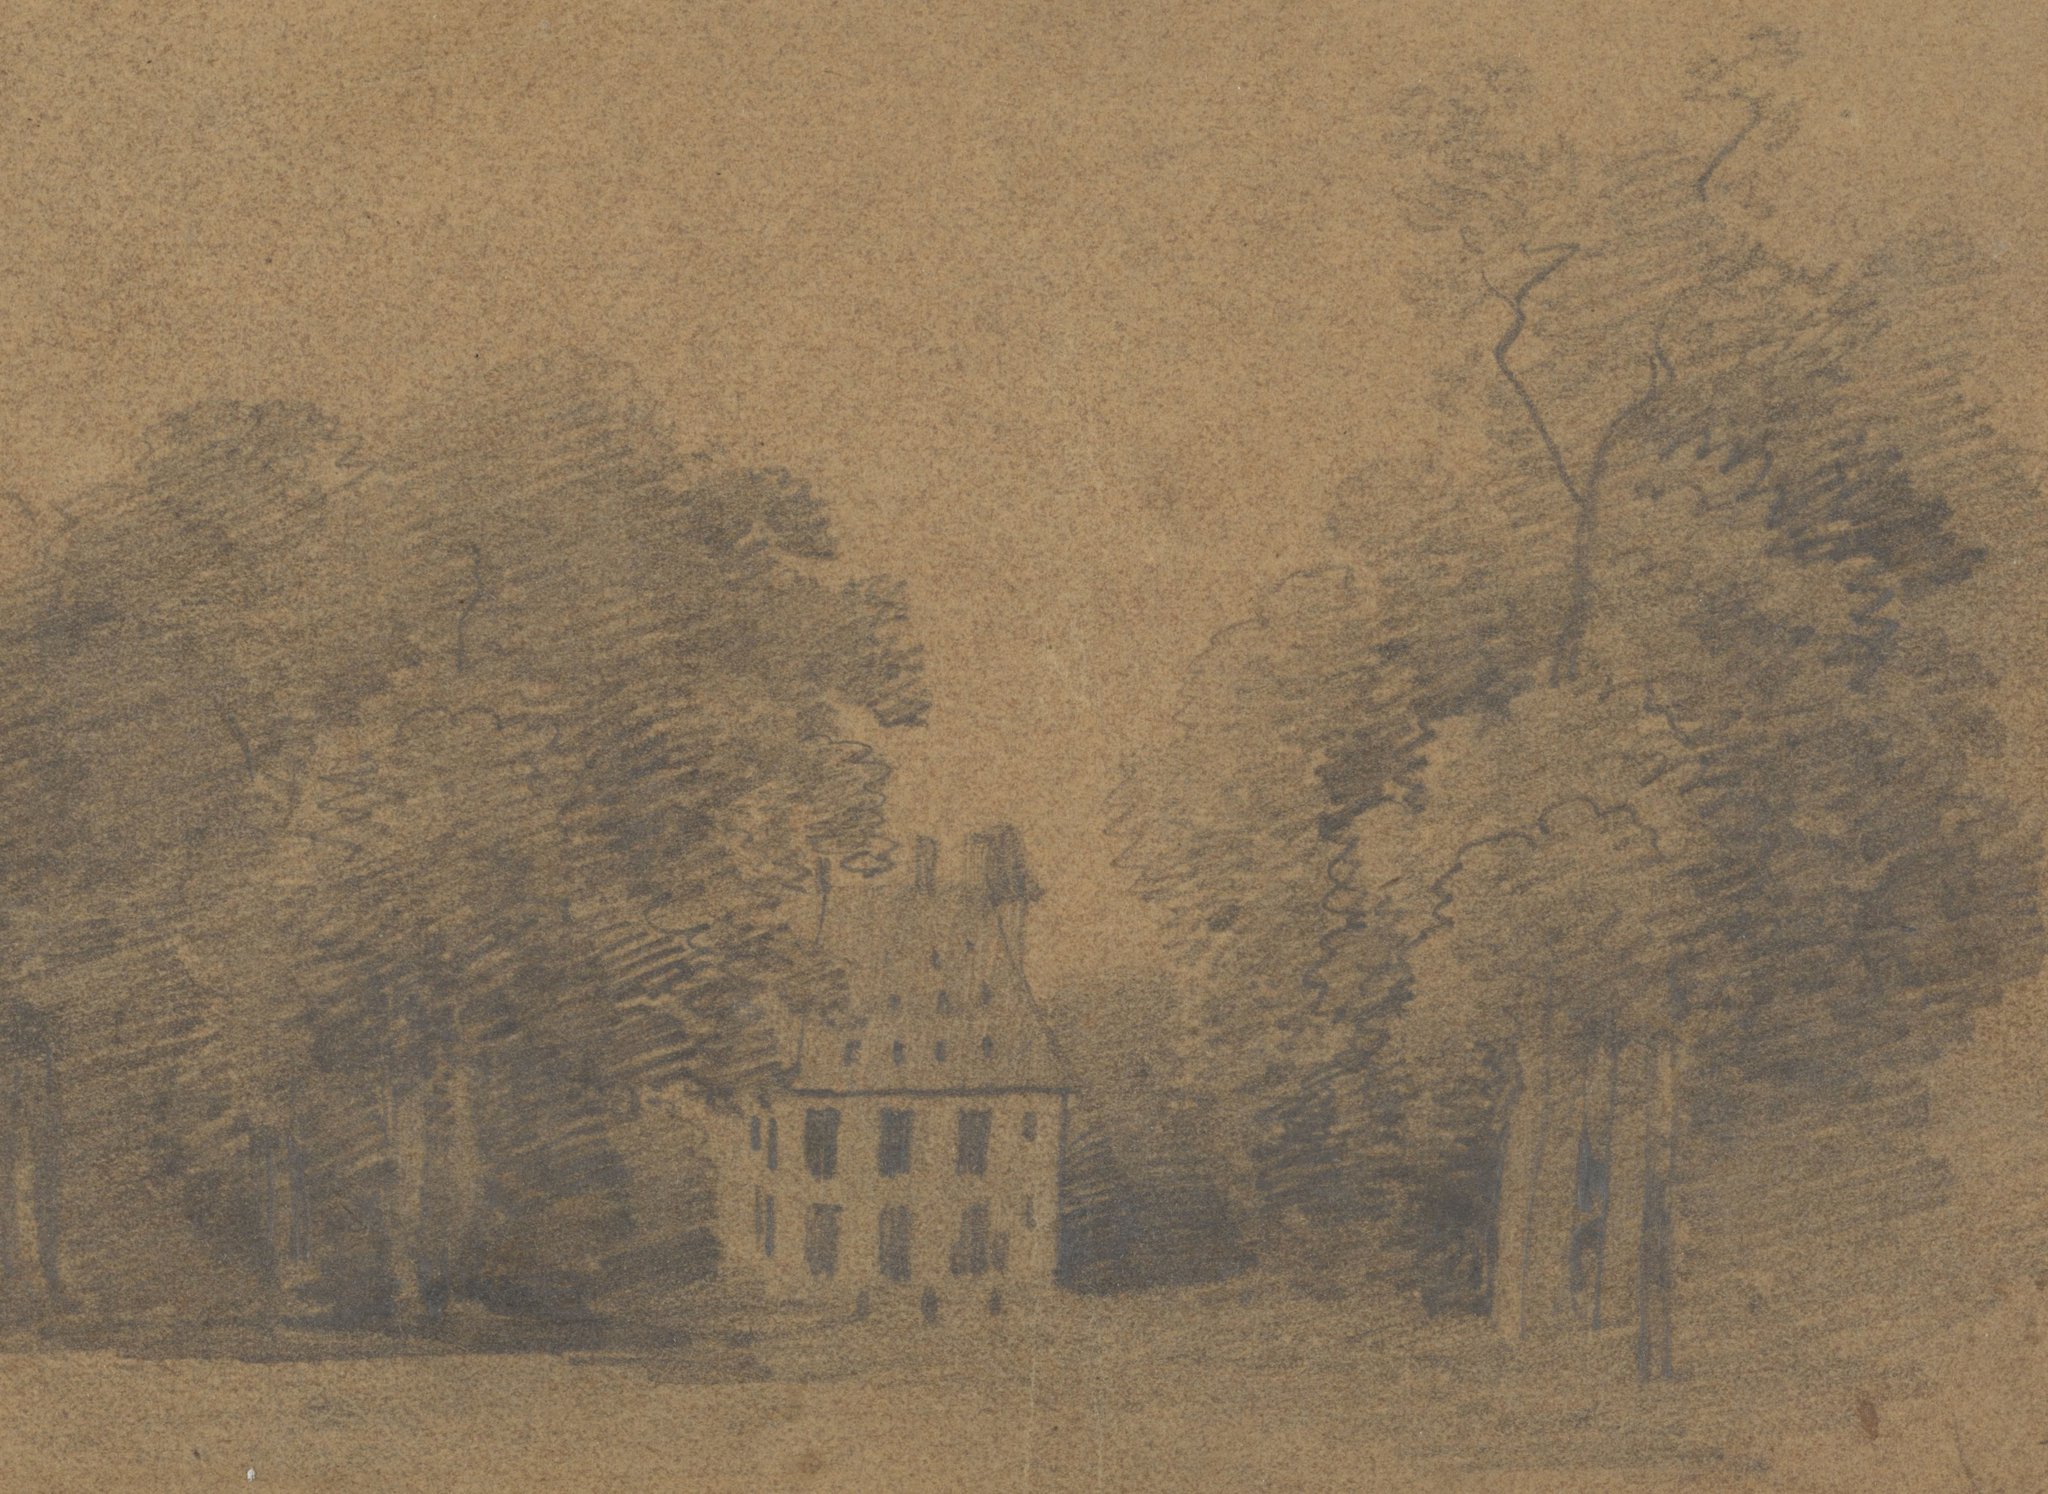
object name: drawing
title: Huis te Voorn bij Utrecht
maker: wijnand nuijen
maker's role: draughtsman, painter, print maker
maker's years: 1813-1839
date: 1823-1839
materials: paper, pencil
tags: castle, utrecht, huis te voorn